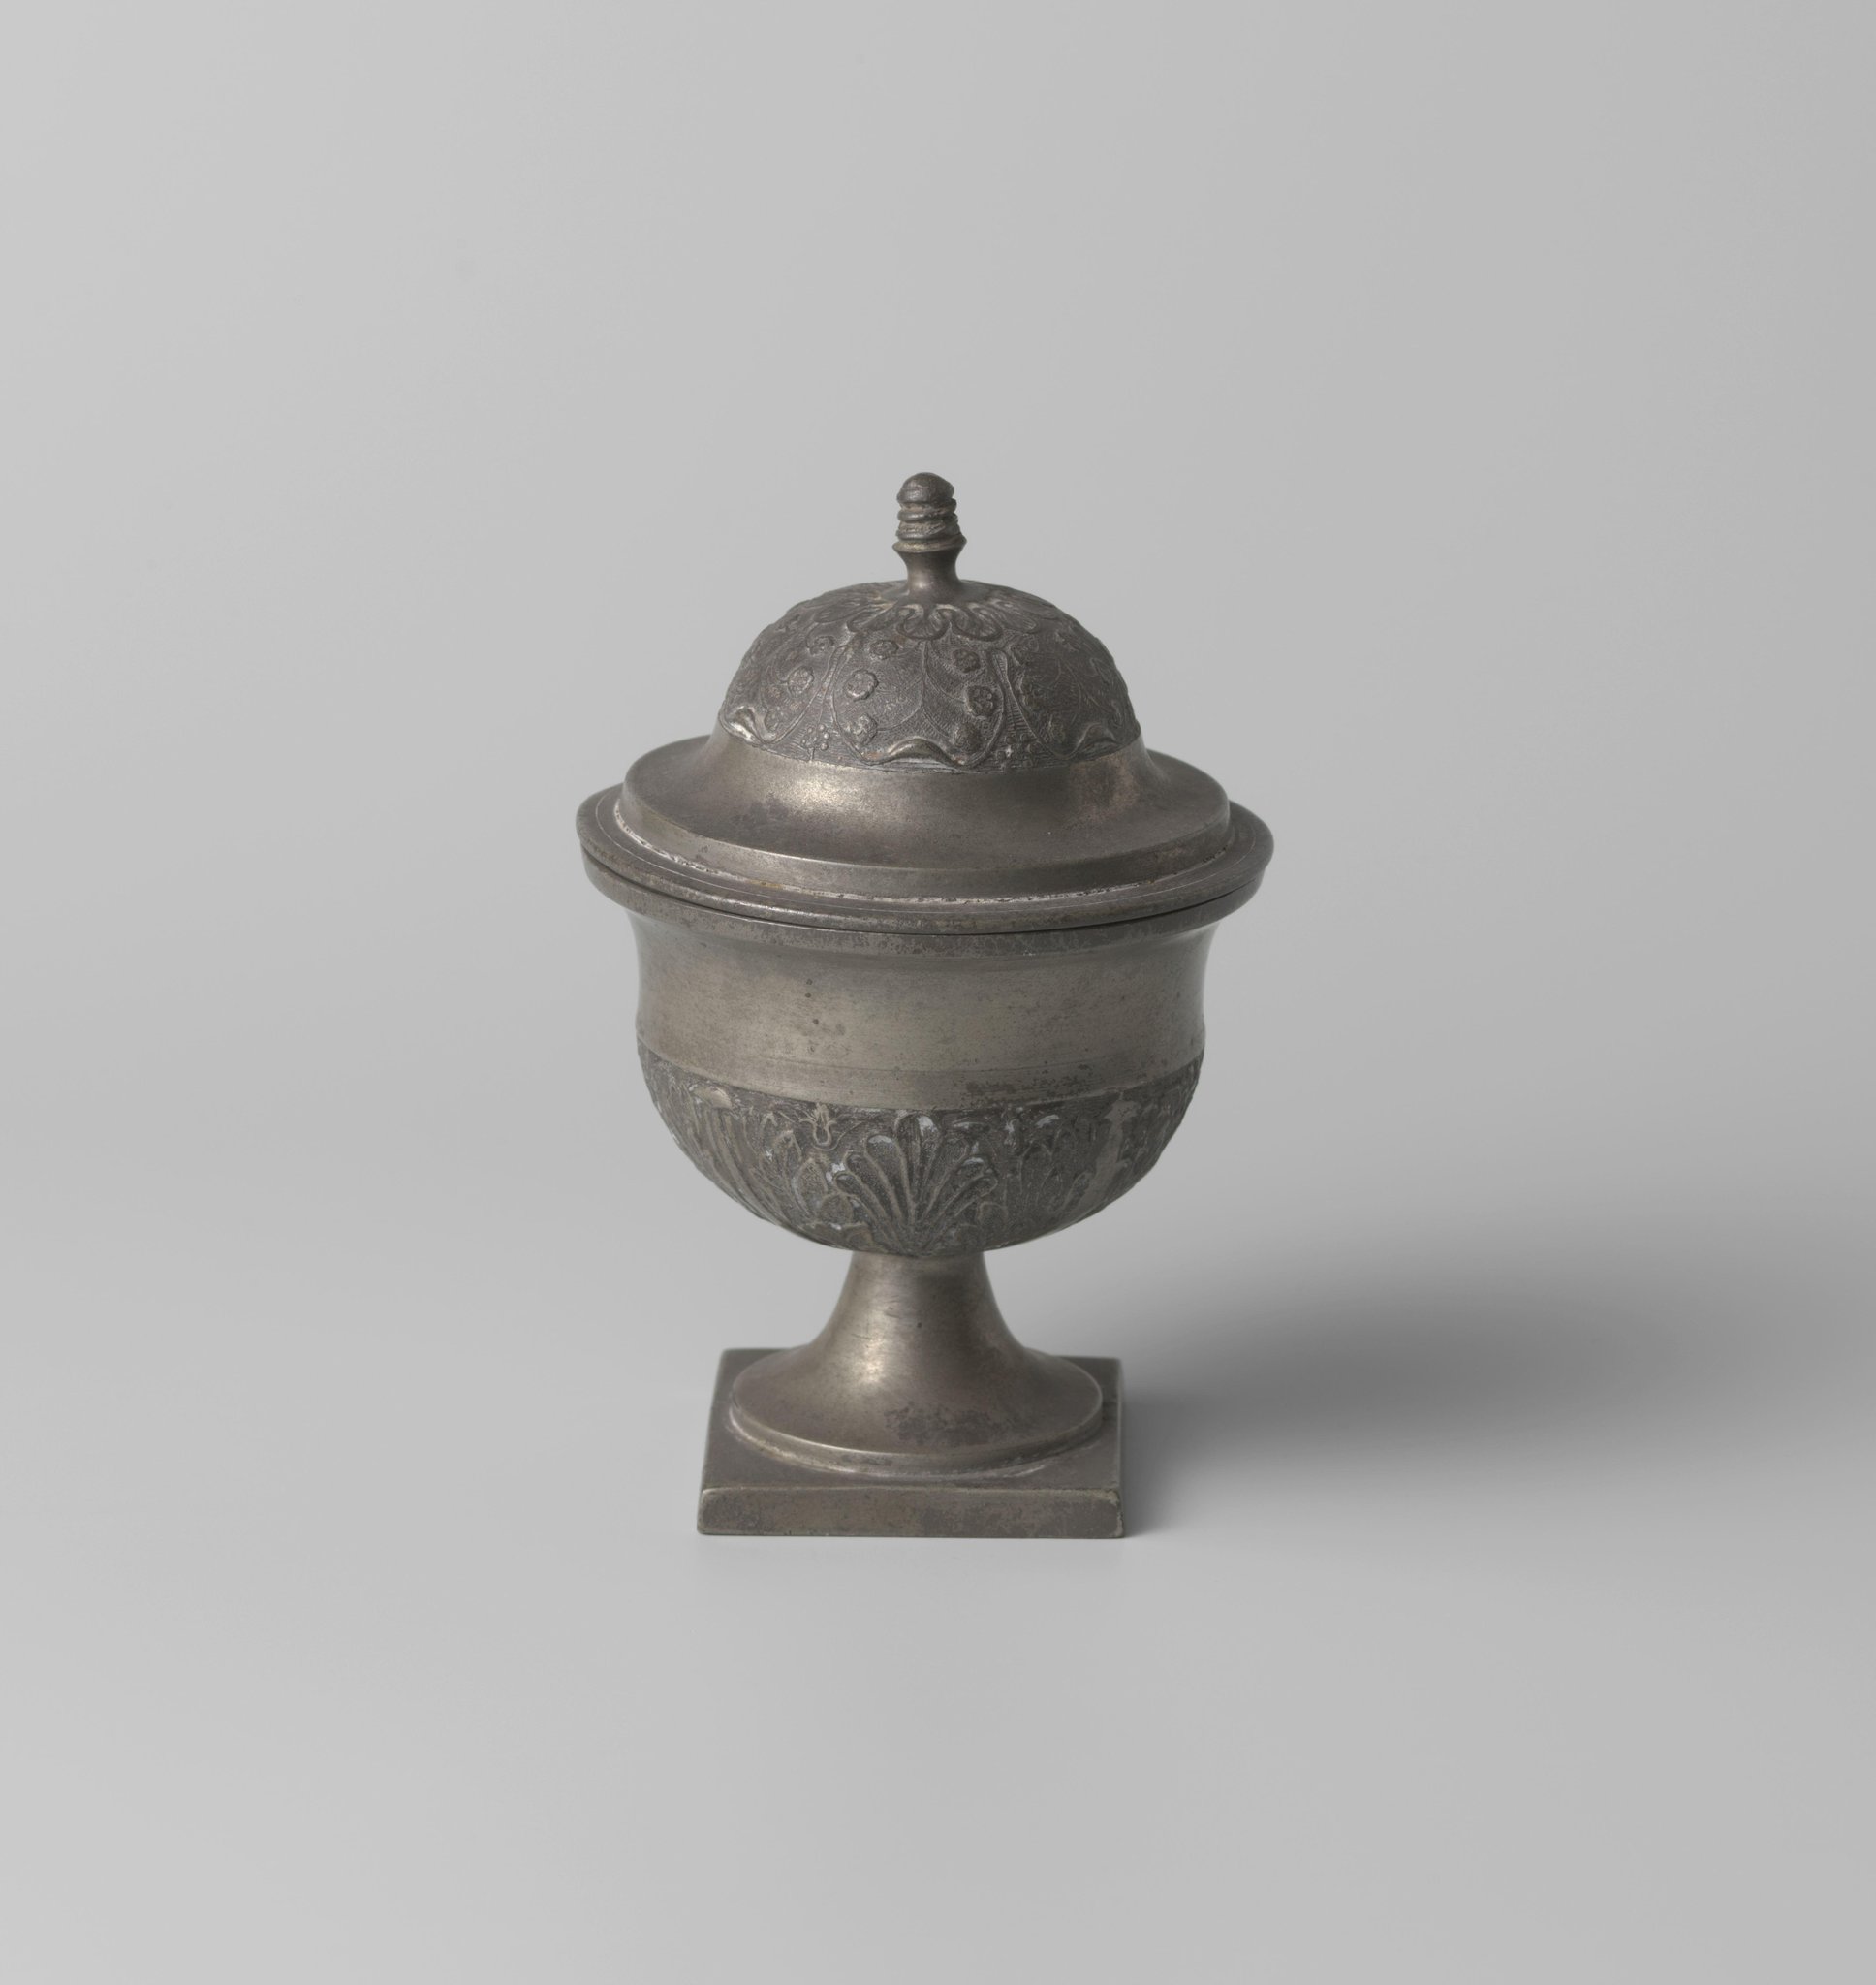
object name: sugar box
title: Suikerpot met deksel van tin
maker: Anonymous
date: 1800-1900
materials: tin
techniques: casting, turning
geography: western europe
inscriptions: quality mark, inscription: ‘IM 15’, inscription: ‘15’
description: Suikerpot met deksel van tin. De pot staat op een vierkante basis, daarop een ronde, conische stam. De cuppa is op de onderste helft gedecoreerd met rankmotieven, de bovenste helft is ongedecoreerd. Het ronde, klokvormige deksel is op de onderste helft ongedecoreerd en op de bovenste helft versierd met rank- en bloemmotieven. De kleine knop is getordeerd.